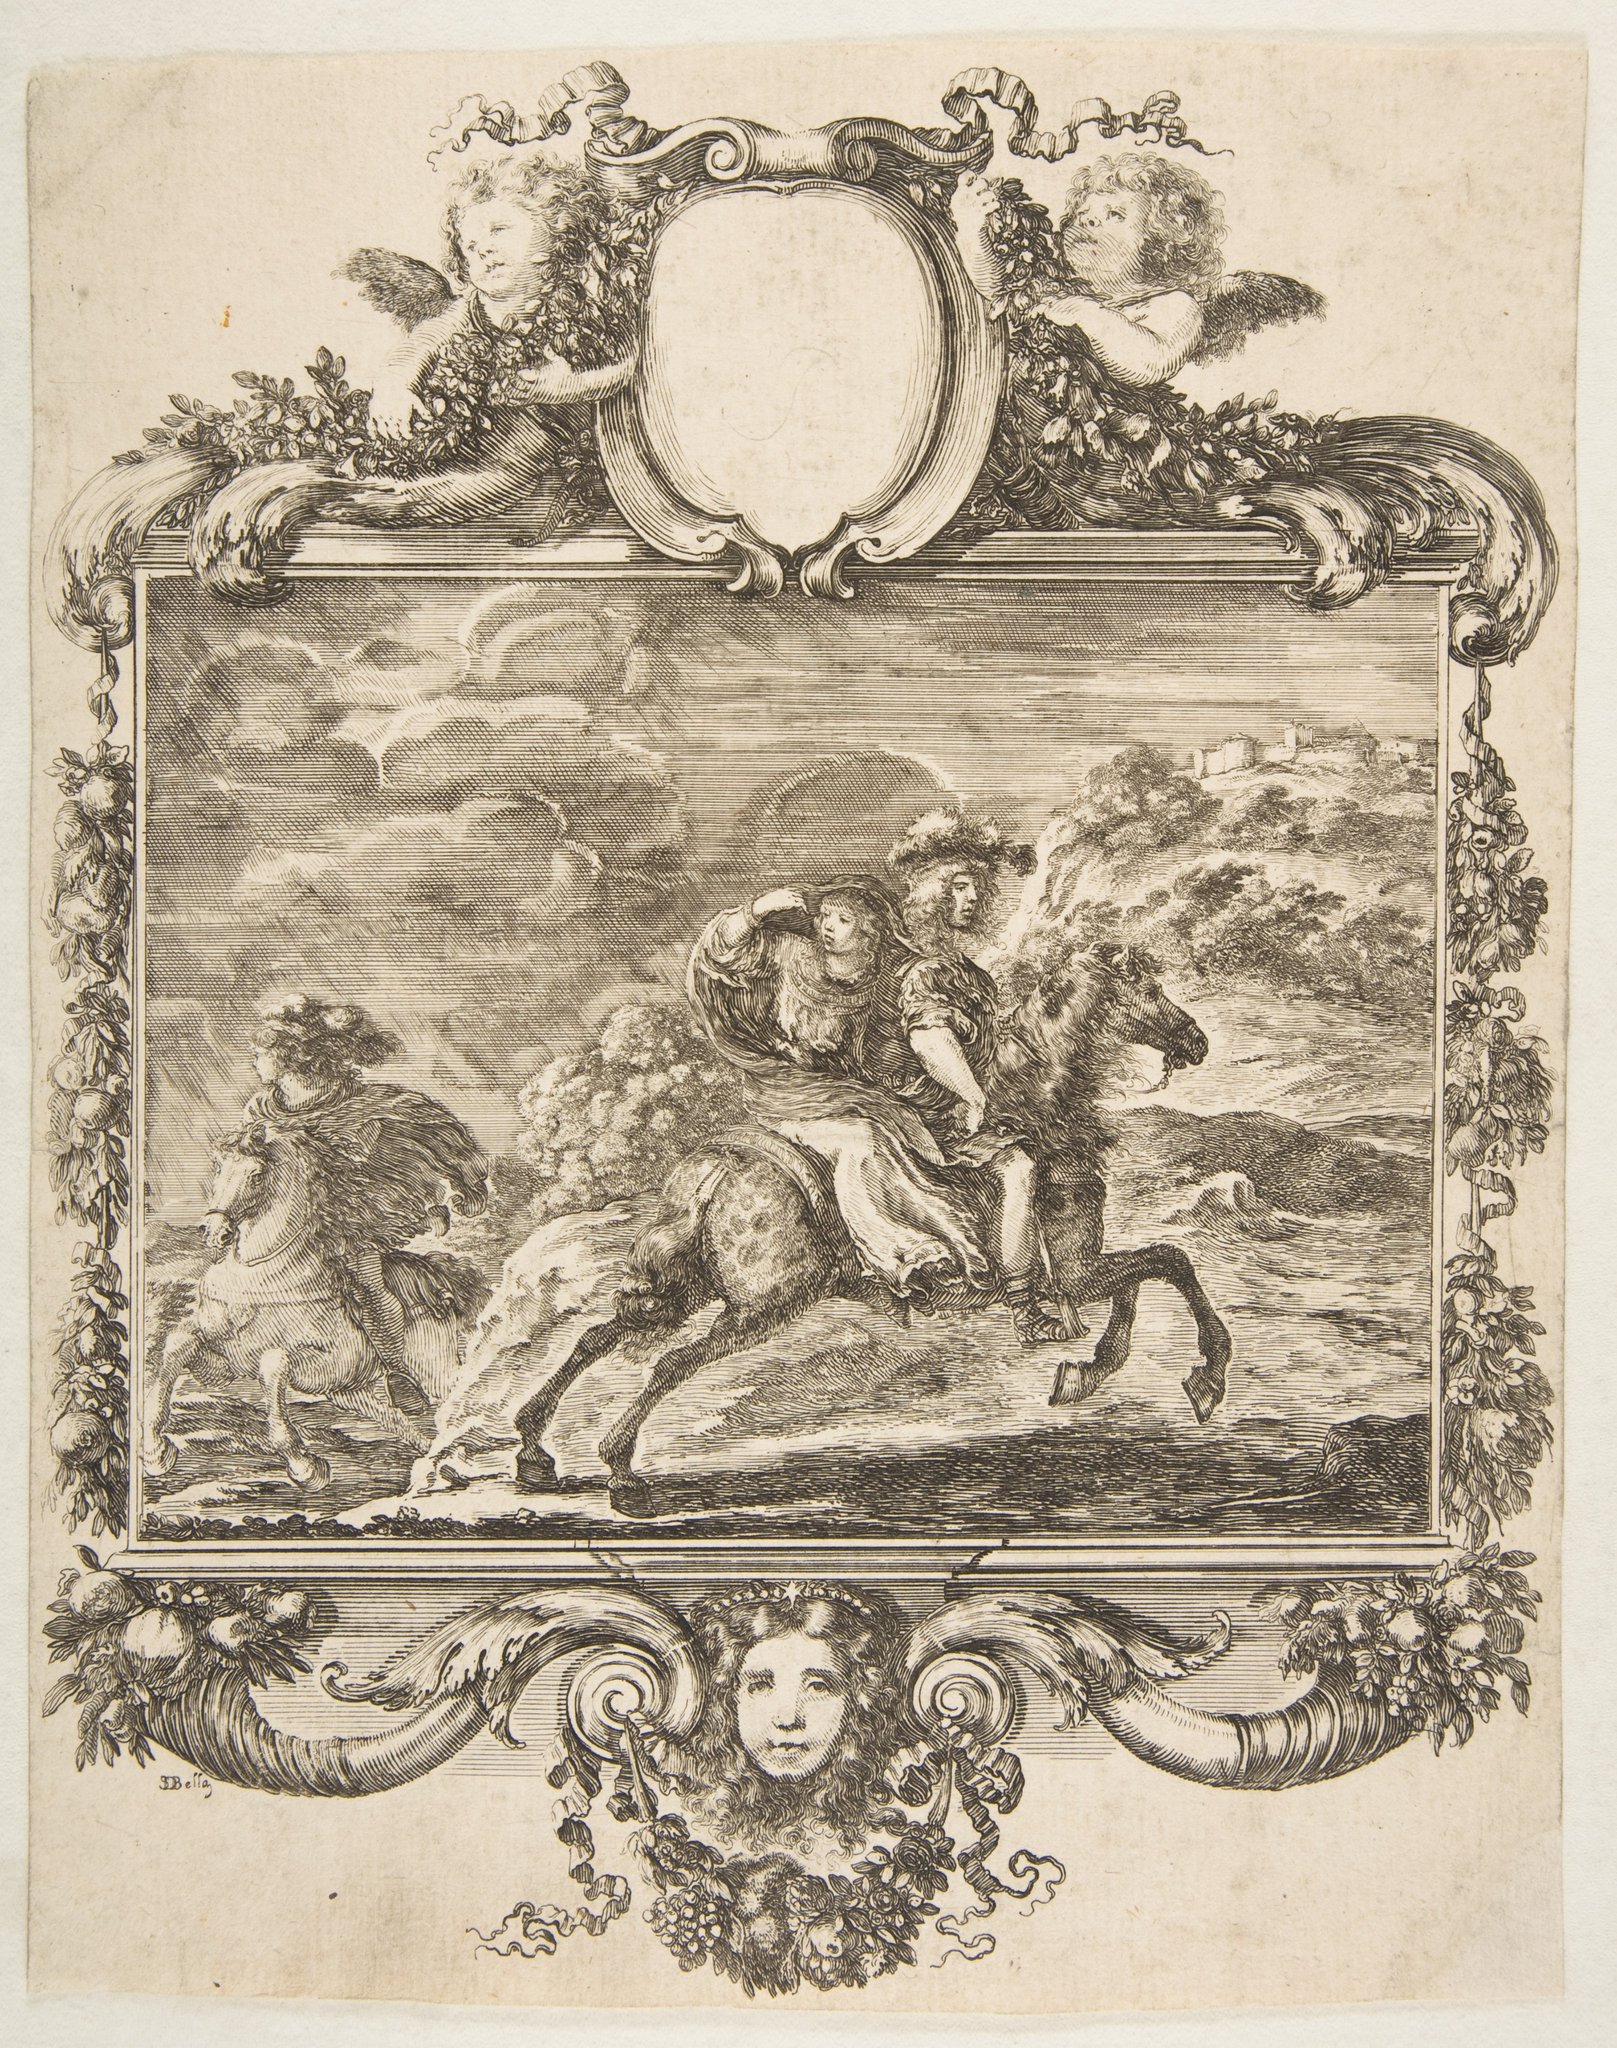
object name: print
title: A cavalier and a lady on horseback, within an ornate border decorated with fruit and cornucopias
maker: stefano della bella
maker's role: artist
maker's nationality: italian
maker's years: 1610-1664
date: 1655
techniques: etching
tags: faces,women,horses,cornucopia